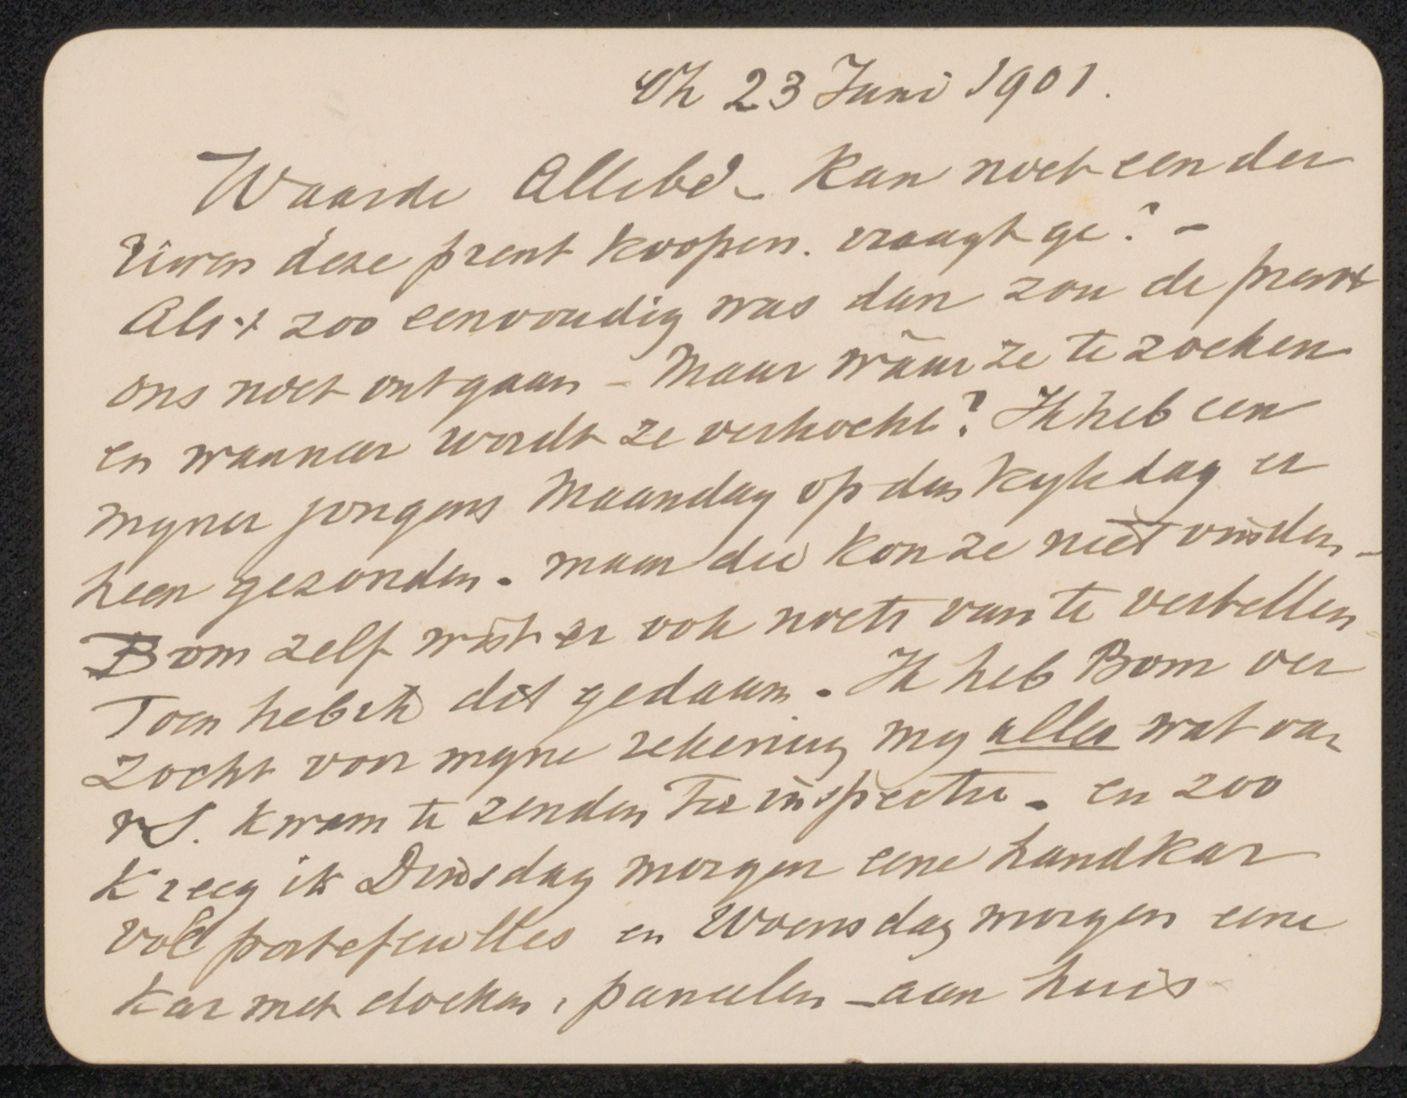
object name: letter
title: Brief aan August Allebé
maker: jan hendrik maschaupt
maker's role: painter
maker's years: 1826-1903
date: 1901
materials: cardboard, ink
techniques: pen, writing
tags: print maker, draughtsman, karl bodmer, august allebé, auctioneer, gerrit dirk bom h.gz., art trade, art shop, the graphic arts